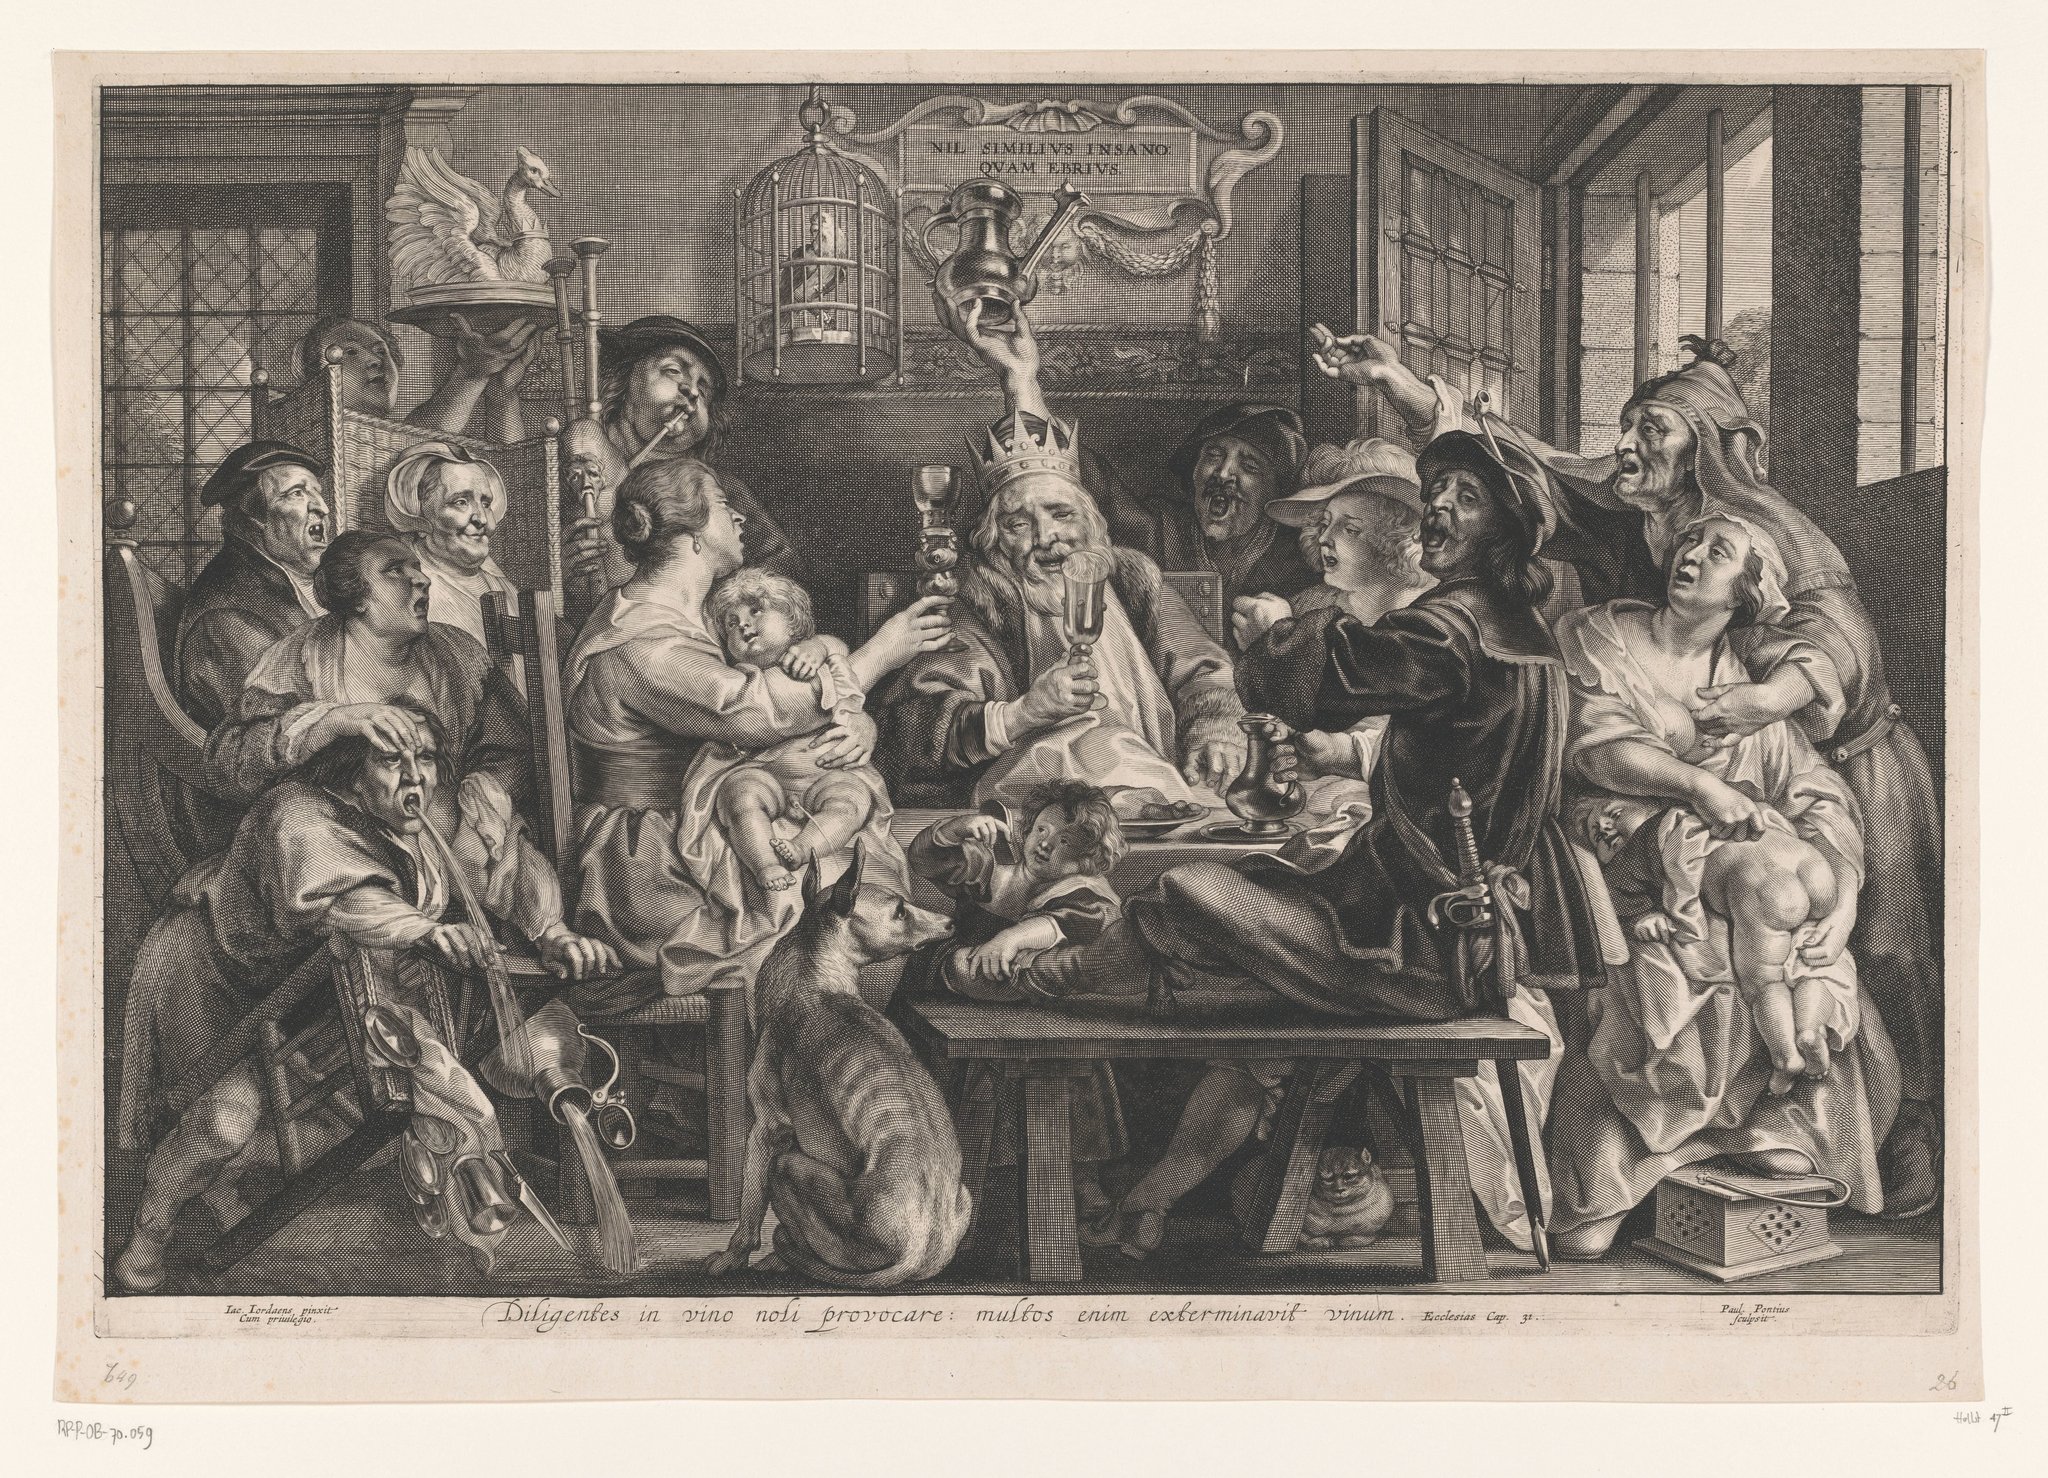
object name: print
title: De koning drinkt (Driekoningen)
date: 1616-1657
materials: paper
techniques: engraving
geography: antwerp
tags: ornamental birds: parrot, twelfth night, usually falling on the eve of january 6, woman-chaser, urination, drunken brawl (usually peasants fighting in an inn)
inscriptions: collector's mark: Lugt 240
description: In een vertrek viert een uitbundig gezelschap Driekoningen. Mannen, vrouwen en kinderen eten, drinken en zingen. In het midden heft de 'koning', een dikke man met papieren koningskroon op het hoofd, zijn glas. Boven zijn hoofd aan de muur hangt een tablet: Nil Similius Insano Quam Ebrius (Niets lijkt meer op een dwaas dan een beschonkene). Daarnaast een papegaai in een vogelkooi. Rechts veegt een vrouw de billen van een kind, terwijl een oude man haar borst grijpt. Vanaf de schoot van zijn moeder plast een kind op een hond die bij de tafel staat. Een man moet overgeven. In de marge een Bijbelcitaat uit Pr. 31 in het Latijn.